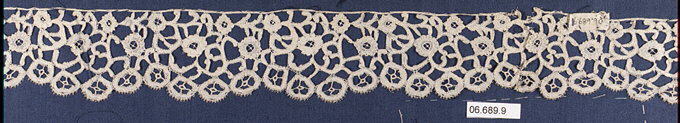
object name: fragment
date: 1801-1833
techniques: lace